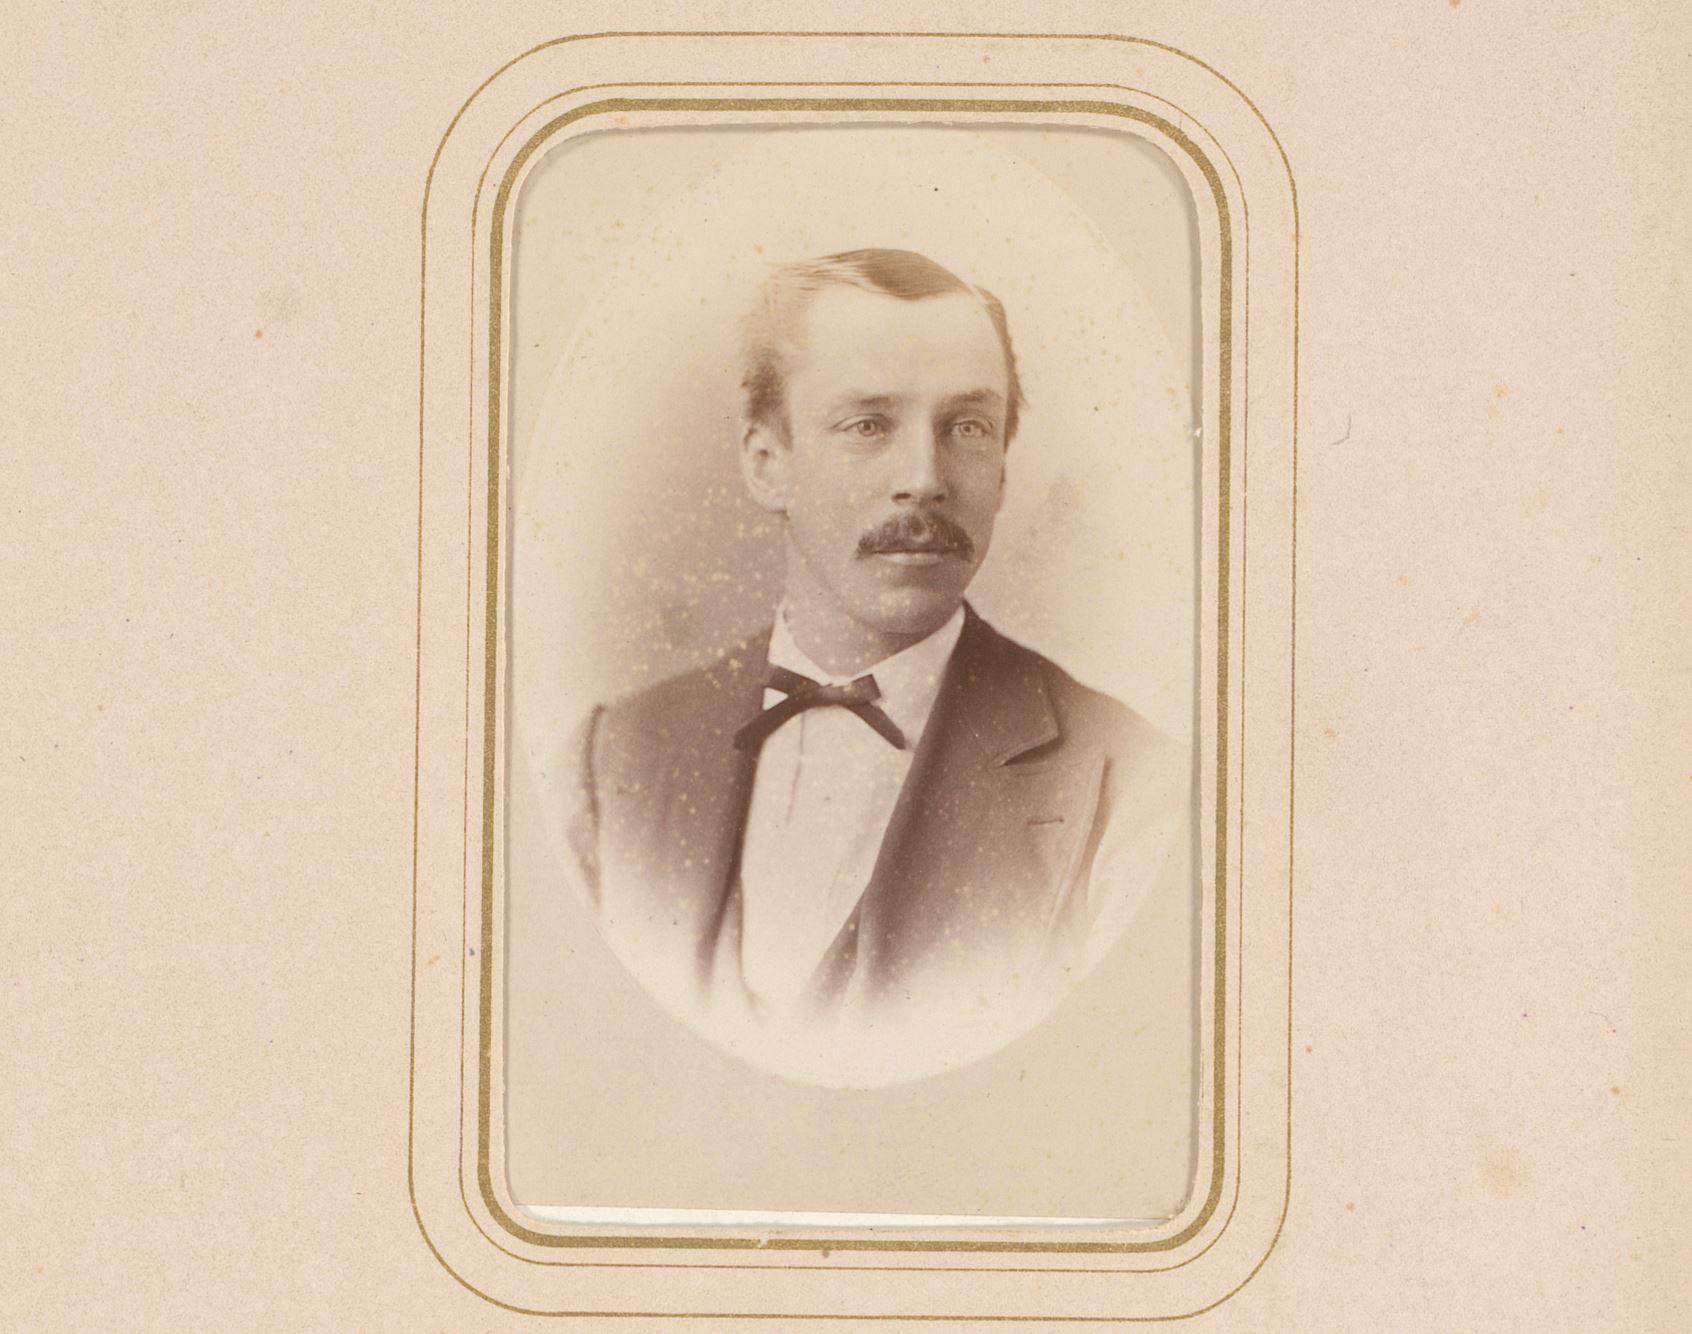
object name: photograph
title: Portret van een man met snor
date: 1876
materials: cardboard, photographic support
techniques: albumen print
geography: dublin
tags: moustache, historical persons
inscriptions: date: ‘1876’, inscription: ‘Notman & Fraser/ W. NOTMAN/ PHOTOGRAPHER TO/ HER MAJESTY/ MONTREAL/ HALIFAX/ AND/ TORONTO’, annotation: ‘With Charlie's love.’